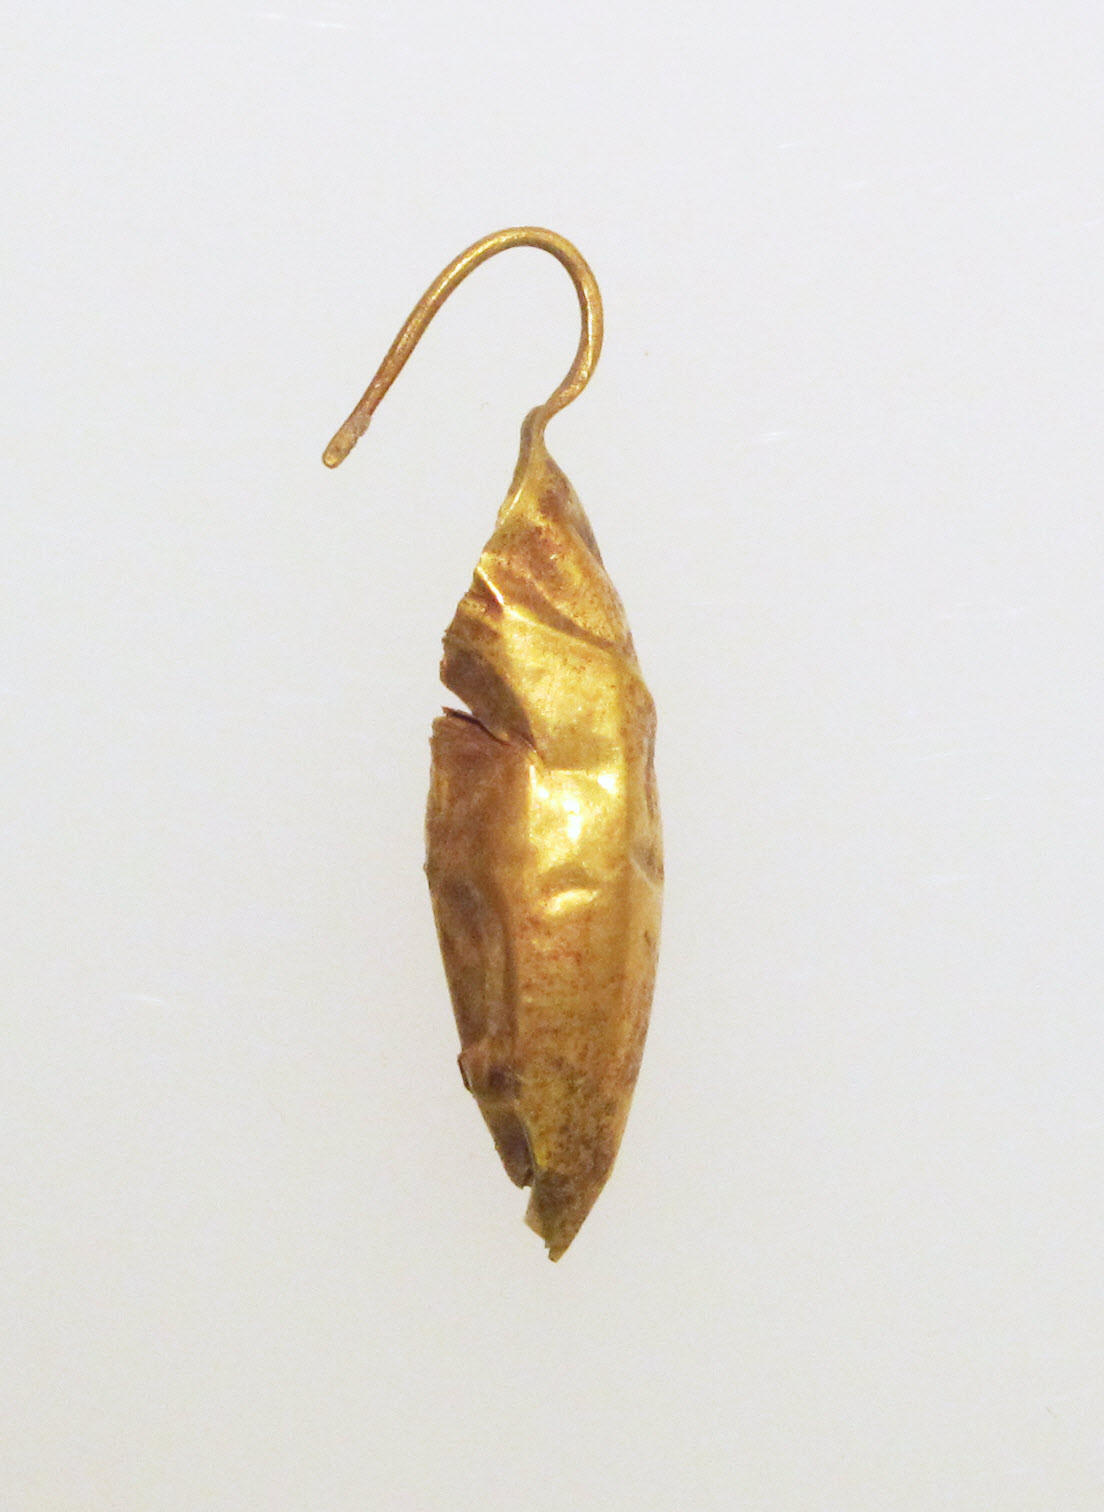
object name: earring hook type with leaf form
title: Earring-hook type with leaf form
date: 7000 BCE-330 CE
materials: gold